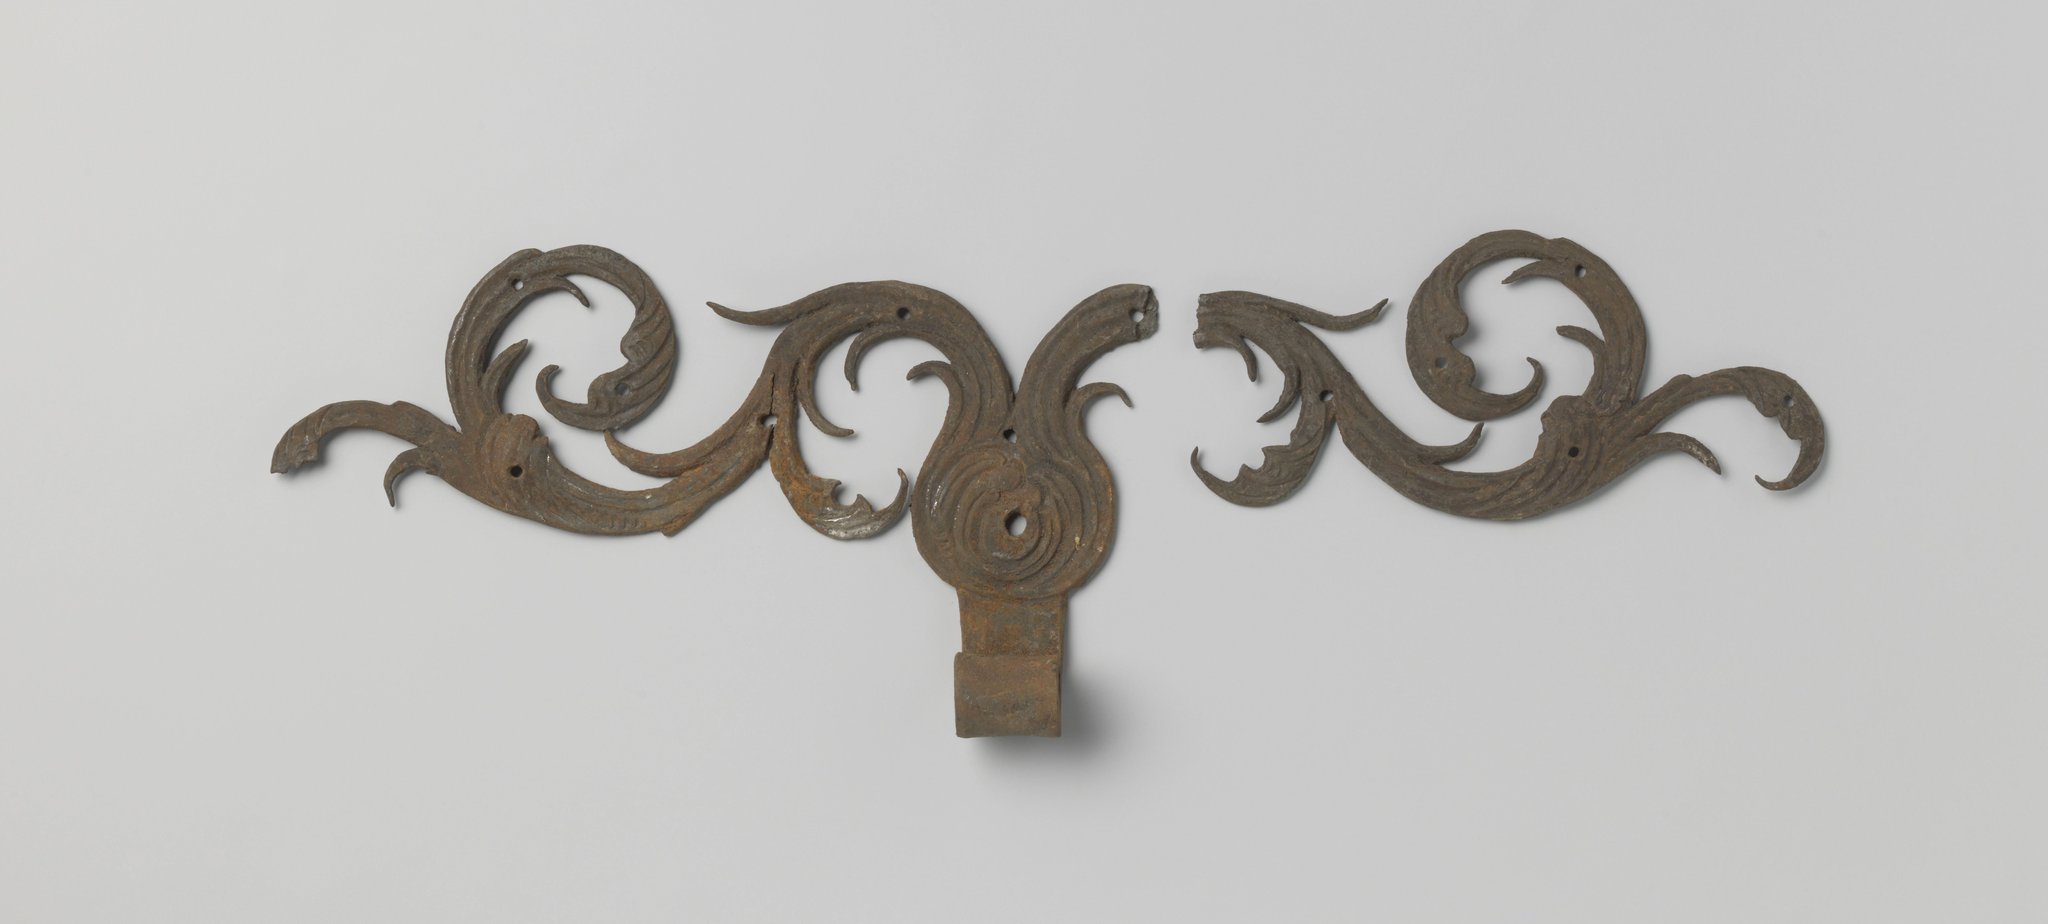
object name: hengsel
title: Hengsel van vertind ijzer met bladmotieven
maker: Anonymous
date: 1600-1800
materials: iron, tin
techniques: metalworking, tinning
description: Hengsel van vertind ijzer. Onderaan een grote, ronde opening van een scharnier met daaraan een ronde aanzet. Van daaruit ontspringen twee symmetrische bladmotieven, die naar het einde toe splitsen.